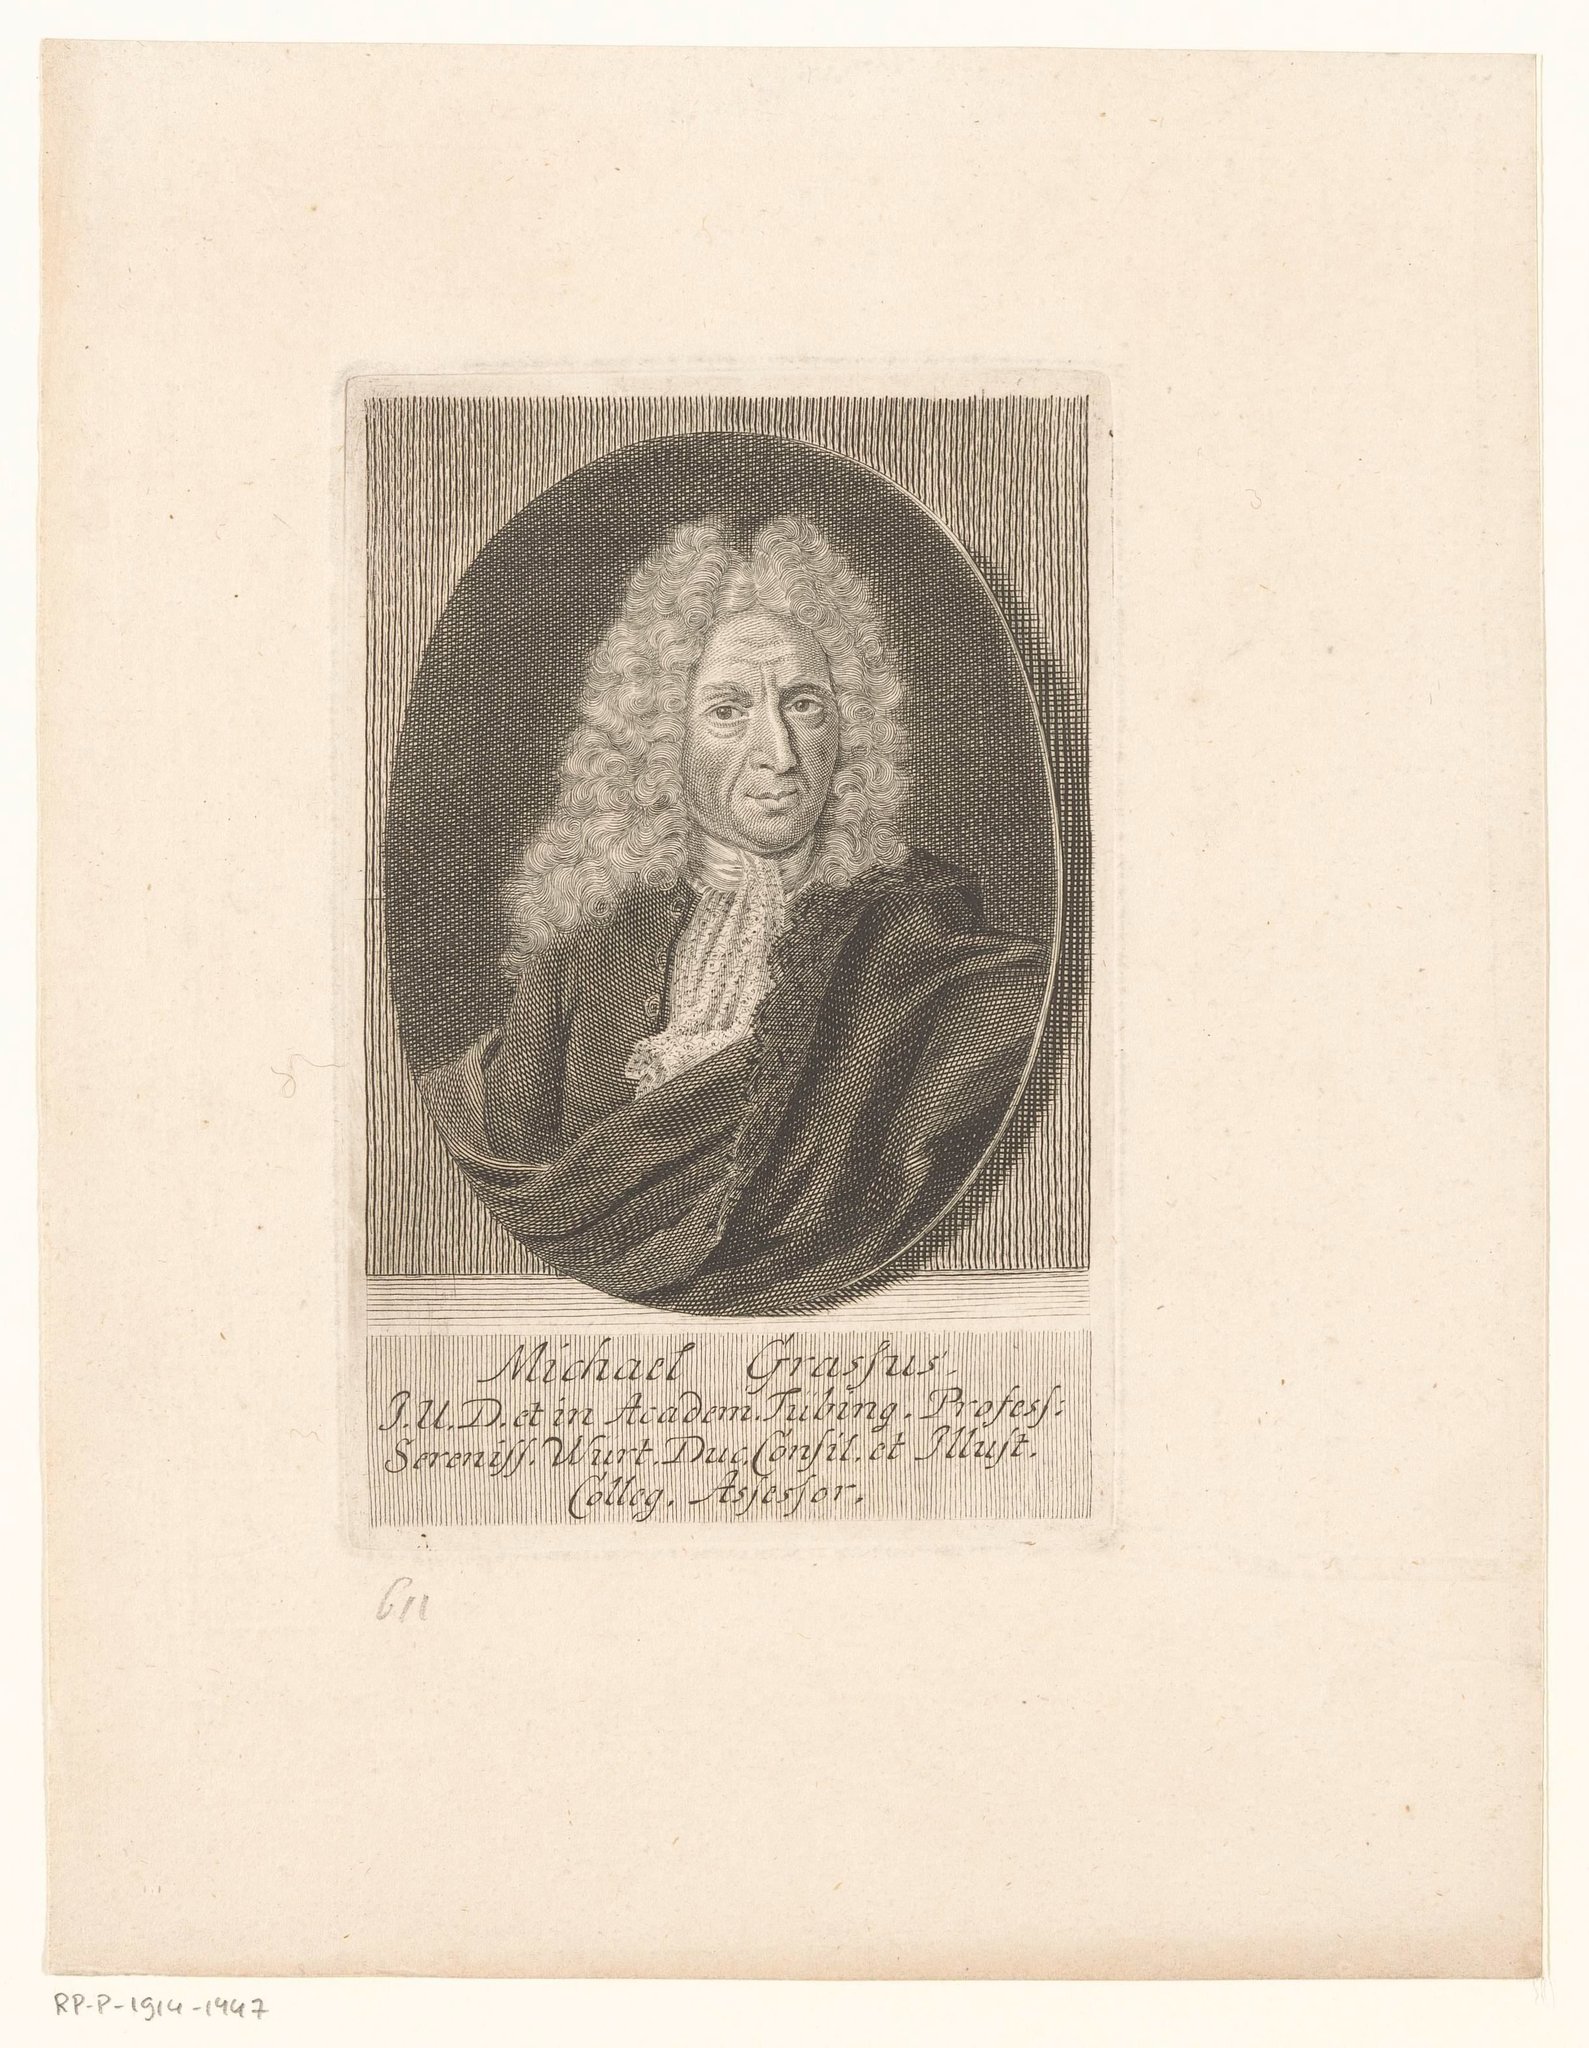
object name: print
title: Portret van Michael Grass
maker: martin bernigeroth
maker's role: print maker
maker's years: 1670-1733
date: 1724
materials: paper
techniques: engraving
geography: leipzig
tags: historical persons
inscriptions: collector's mark: Lugt 2228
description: Prent ook gebruikt in: Deutsche Acta Eruditorum (...). dl. 101. Leipzig: Johann Gottlieb Gleditsch, 1724.